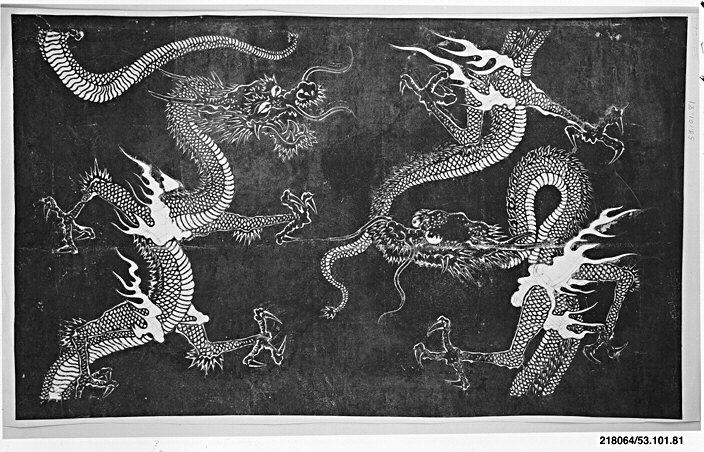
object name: stencil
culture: japanese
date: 1615-1868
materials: paper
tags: dragons